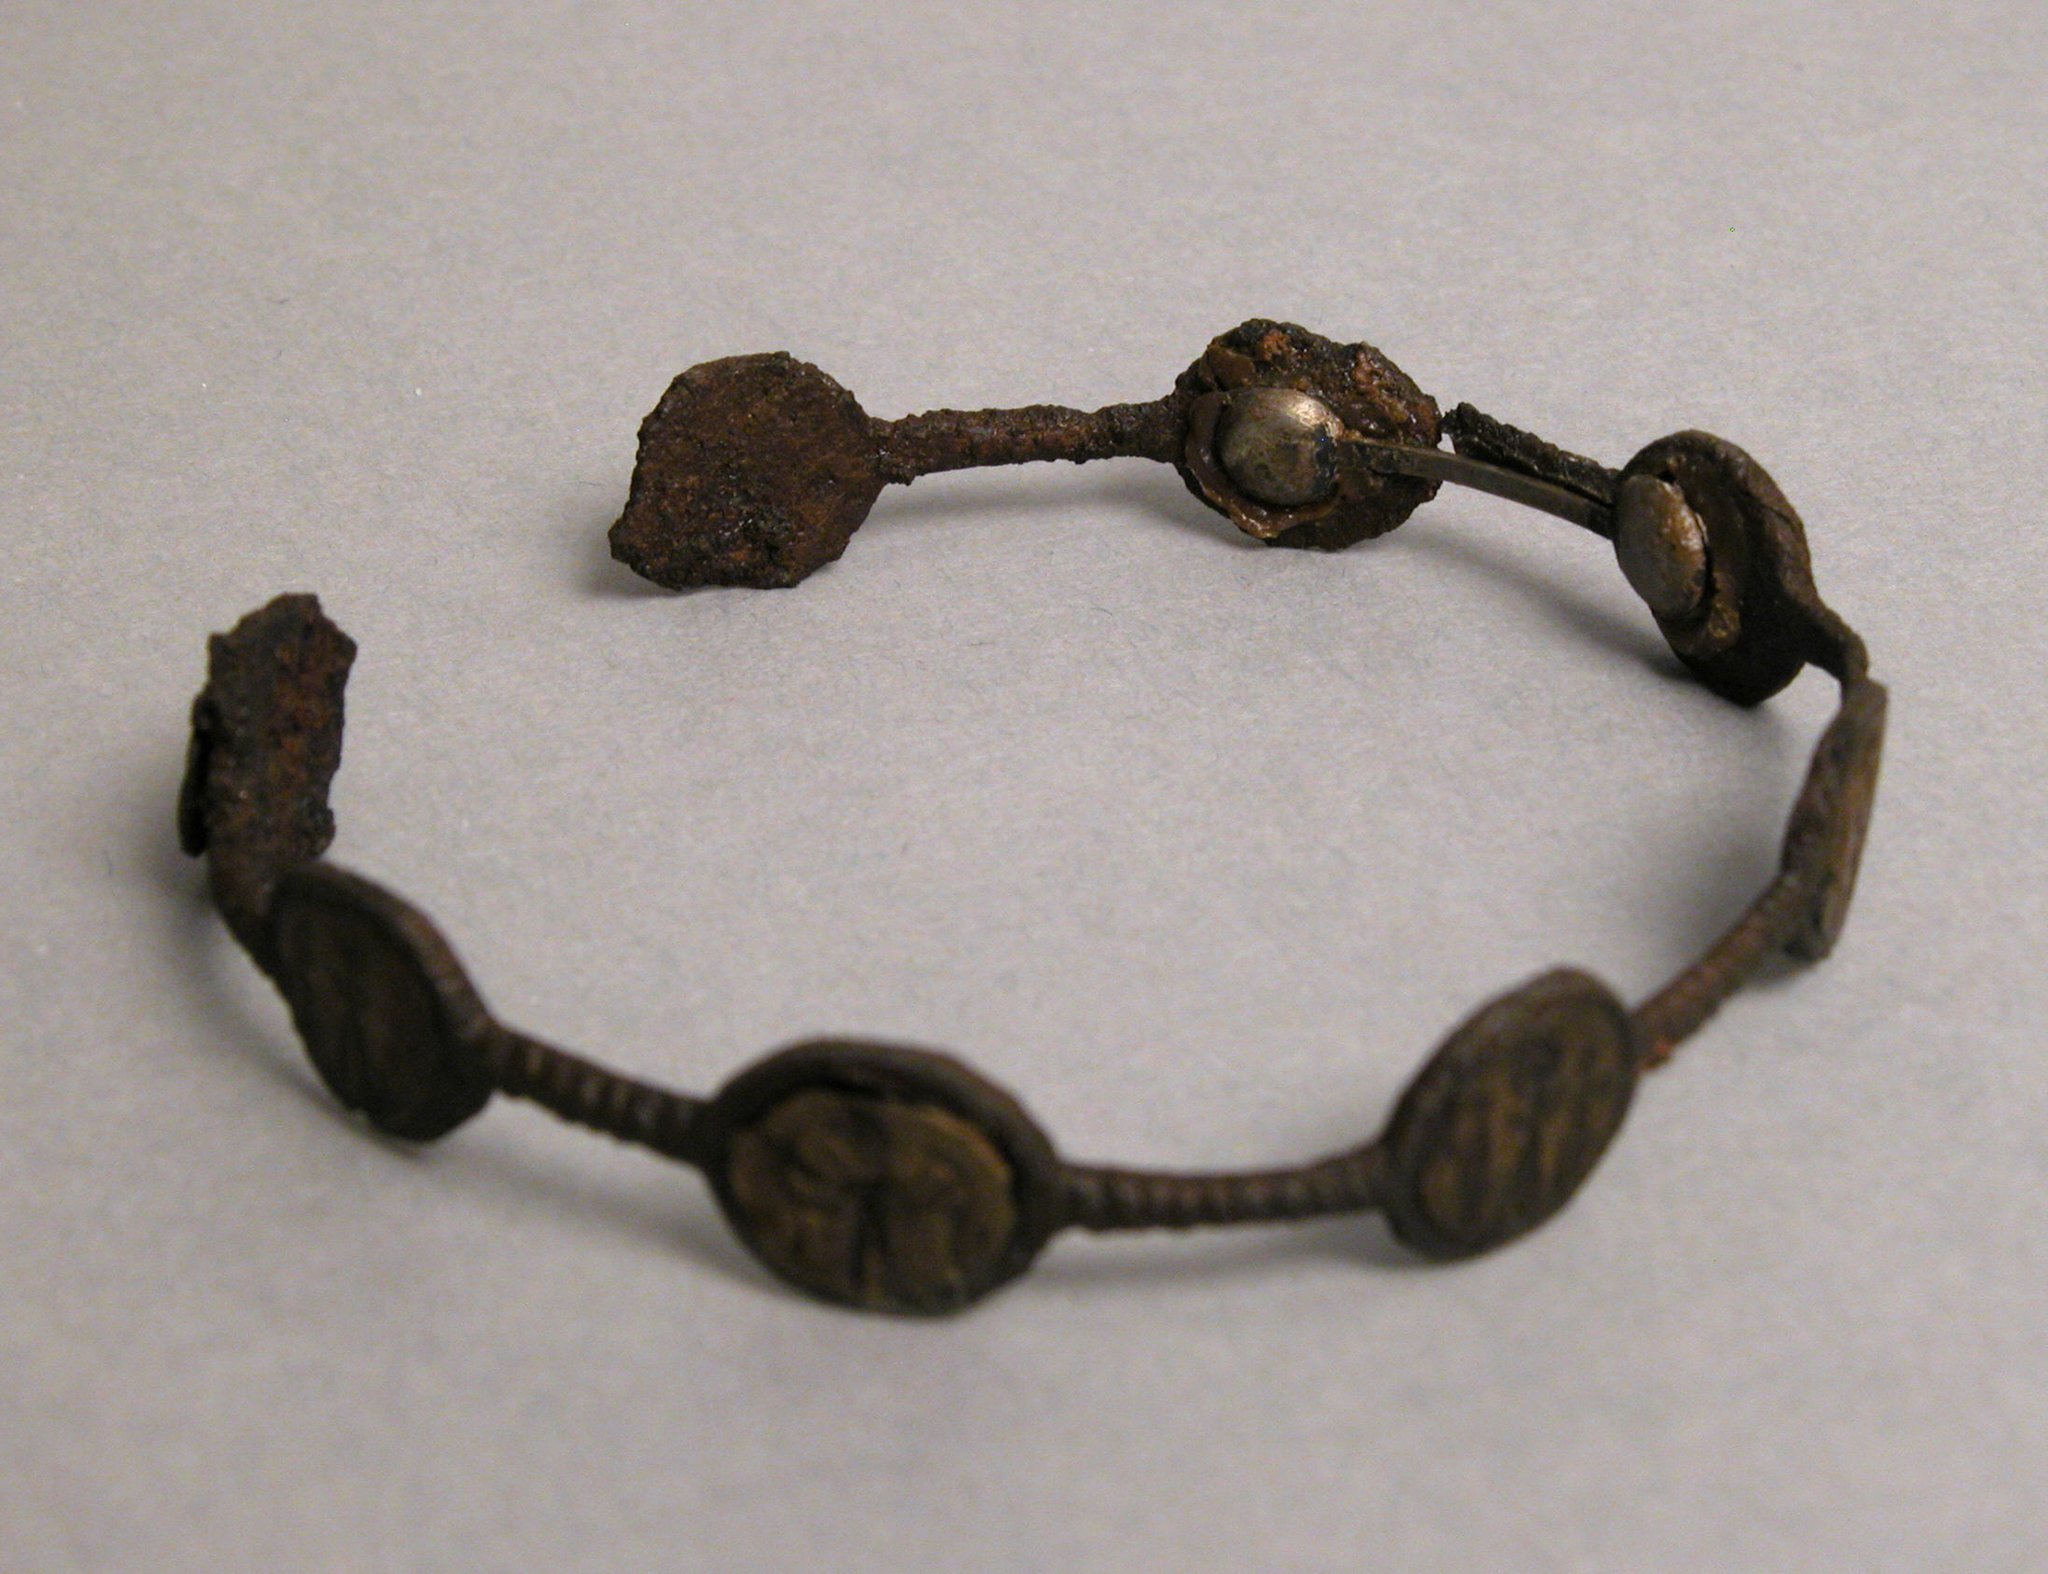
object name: bracelet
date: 501-700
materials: bronze, iron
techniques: inlay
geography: egypt